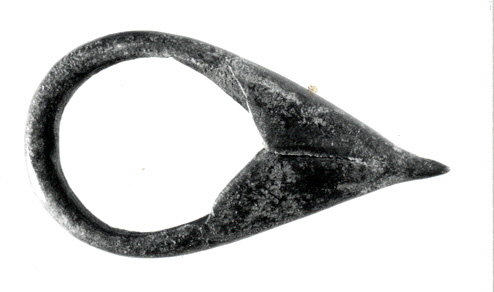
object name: ornament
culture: middle niger civilization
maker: middle niger artist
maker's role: artist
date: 801-1700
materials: copper alloy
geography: mali